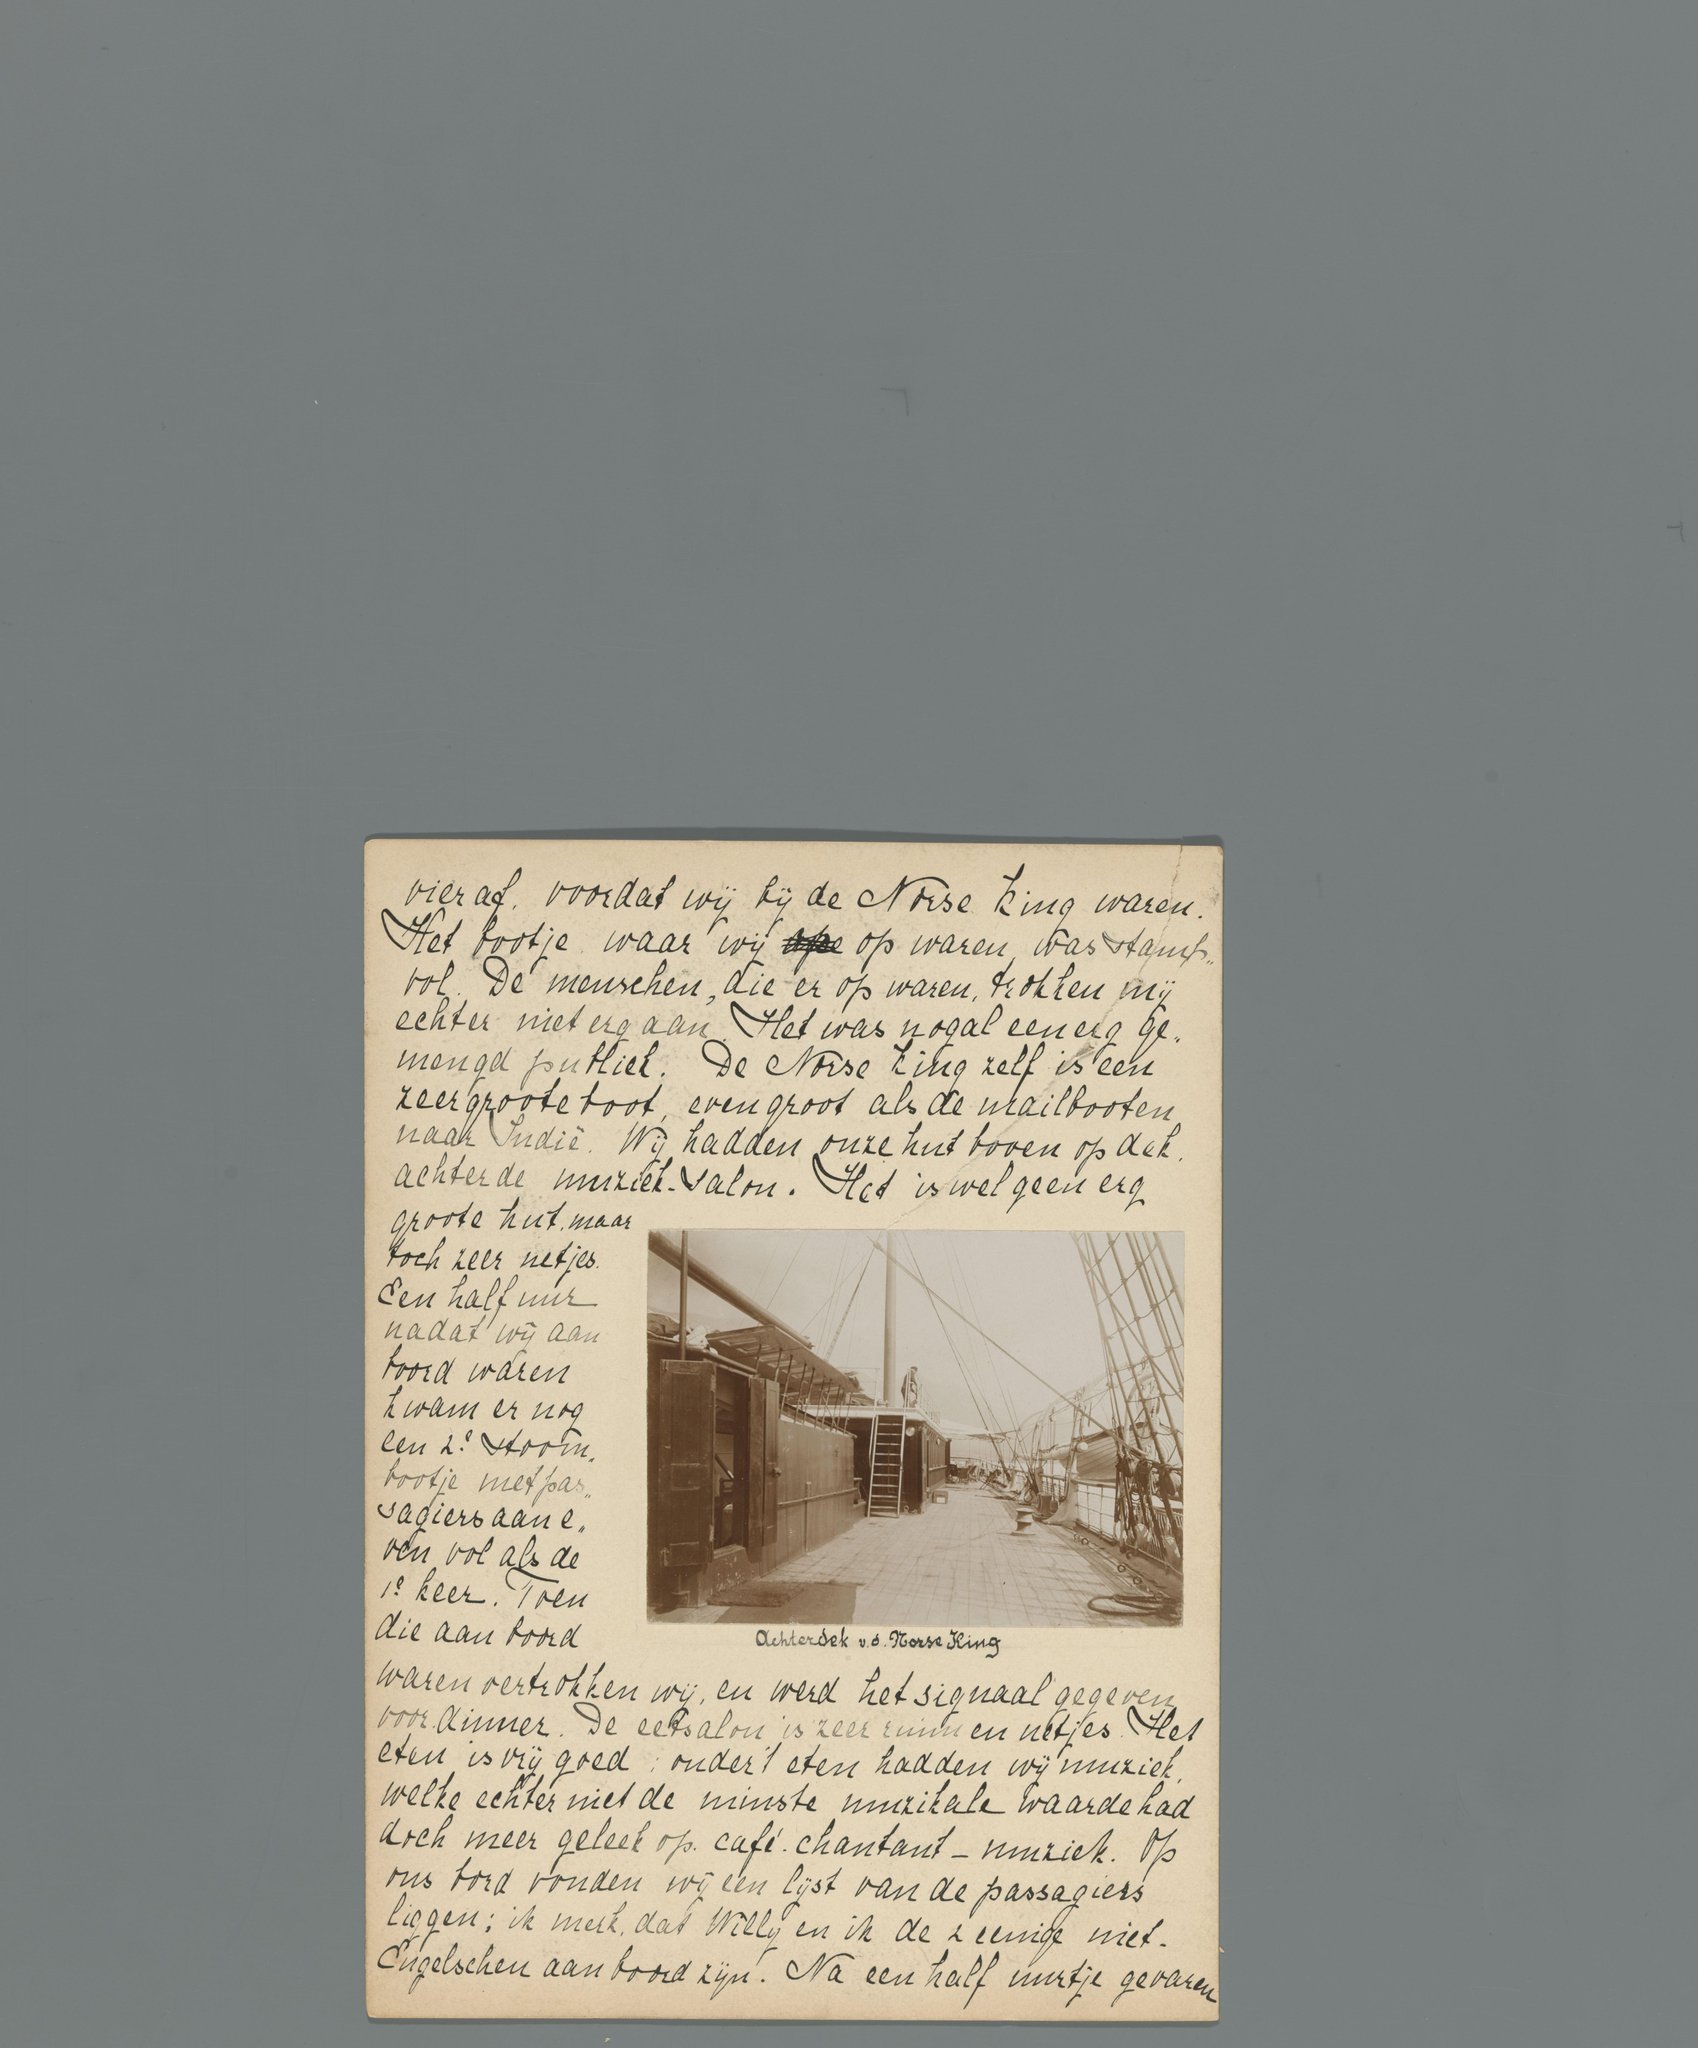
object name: photograph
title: Vierde pagina van een dagboek van een reis door Noorwegen met een foto van het achterdek van de Norse King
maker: hendrik herman van den berg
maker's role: amateurfotograaf, jurist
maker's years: 1875-1944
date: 1895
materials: paper, ink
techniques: pen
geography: norway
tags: batavia, amsterdam, hendrik herman van den berg, parts of ship's exterior, handwriting, written text, 'en route', traveller under way, norway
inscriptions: caption: ‘Achterdek v.d. Norse King’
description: Vierde pagina van een dagboek met het verslag van een reis door Noorwegen gemaakt door Hendrik Herman van den Berg en zijn neef Guillaume Louis Jacques Holle tussen 5 en 20 juli 1895. Op het dagboekblad is een foto geplakt van het achterdek van de Norse King, de boot waarmee het gezelschap naar Noorwegen voer.